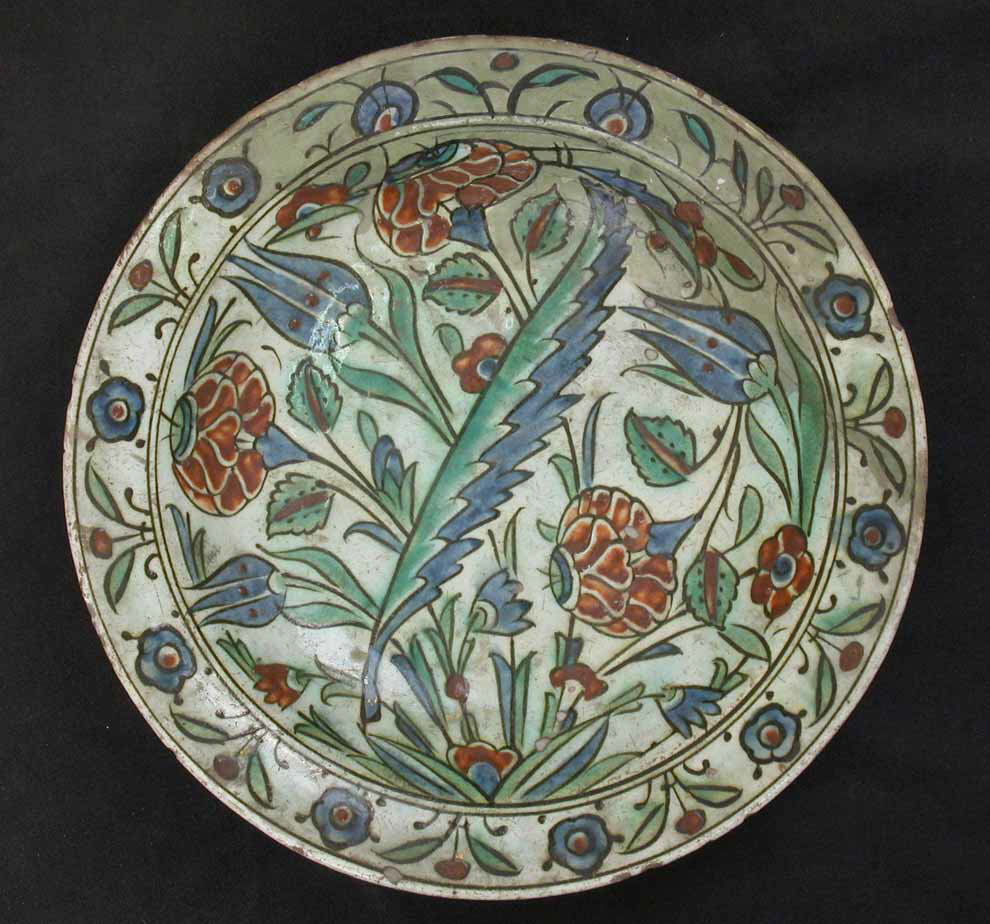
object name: dish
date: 1601-1700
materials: stonepaste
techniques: painting, underglaze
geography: turkey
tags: flowers,leaves